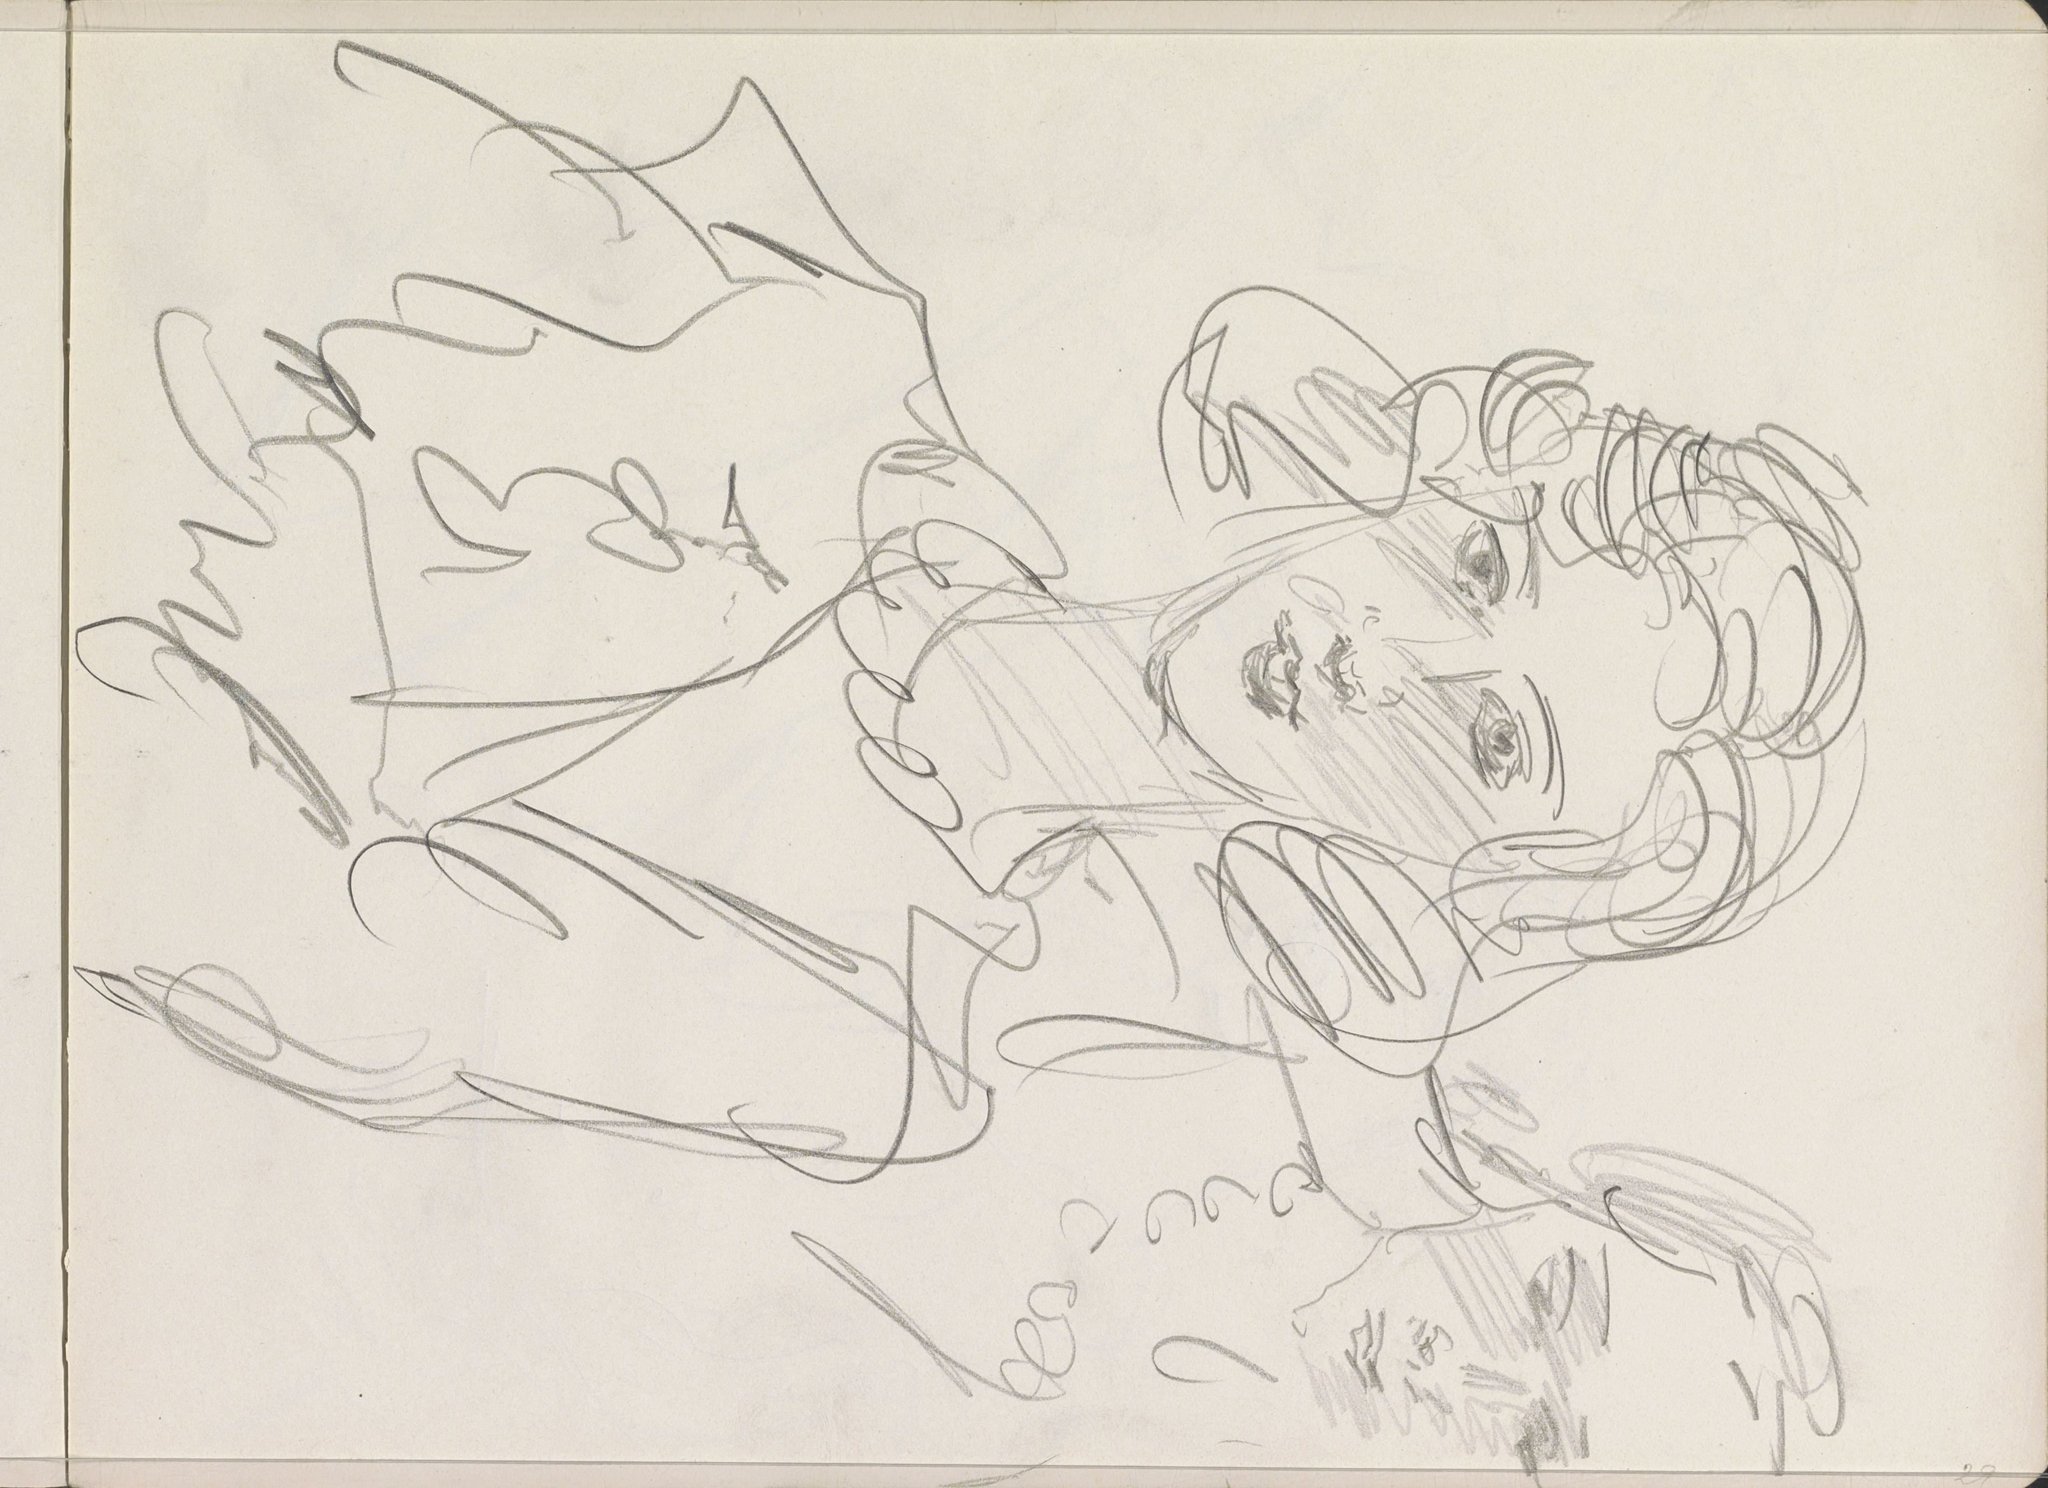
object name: sketchbook leaf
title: Twee vrouwen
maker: isaac israels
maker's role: draughtsman, painter, print maker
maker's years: 1865-1934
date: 1915-1934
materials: paper, pencil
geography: the hague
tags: adult woman (+ two persons)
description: Blad 29 recto uit schetsboek III met 36 bladen.